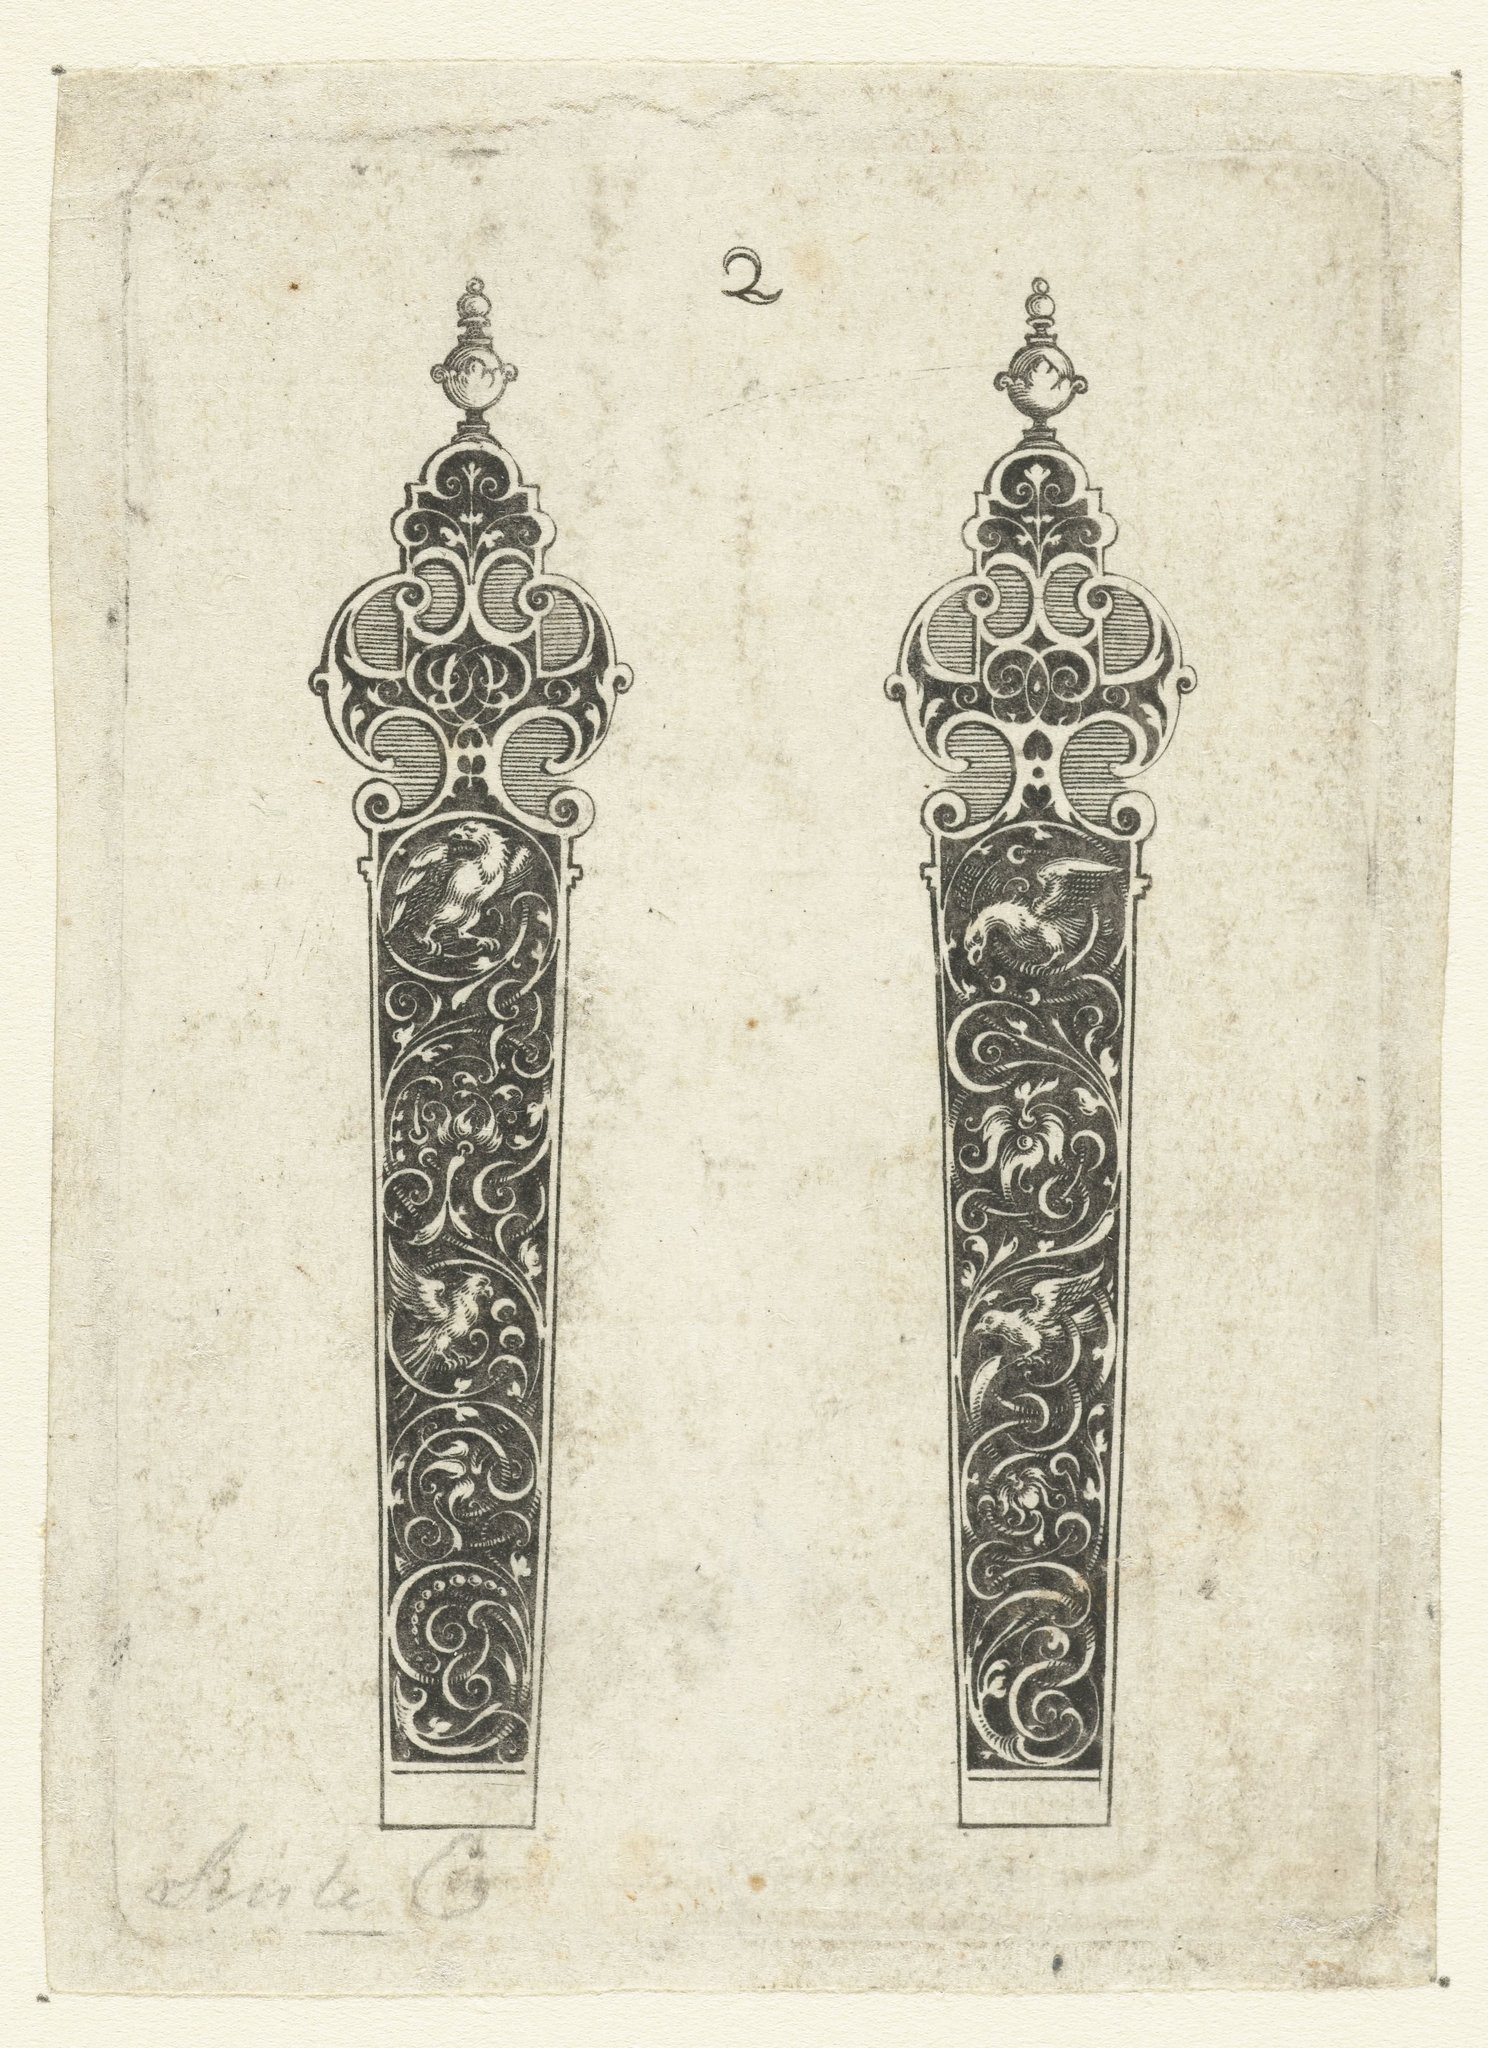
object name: print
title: Twee messenheften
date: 1597-1656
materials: paper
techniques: etching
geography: amsterdam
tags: table-knife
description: Op elk blad uit deze serie staan twee symmetrische messenheften met bovenaan een kraal. De heften zijn versierd met ranken waartussen zich twee vogels bevinden.